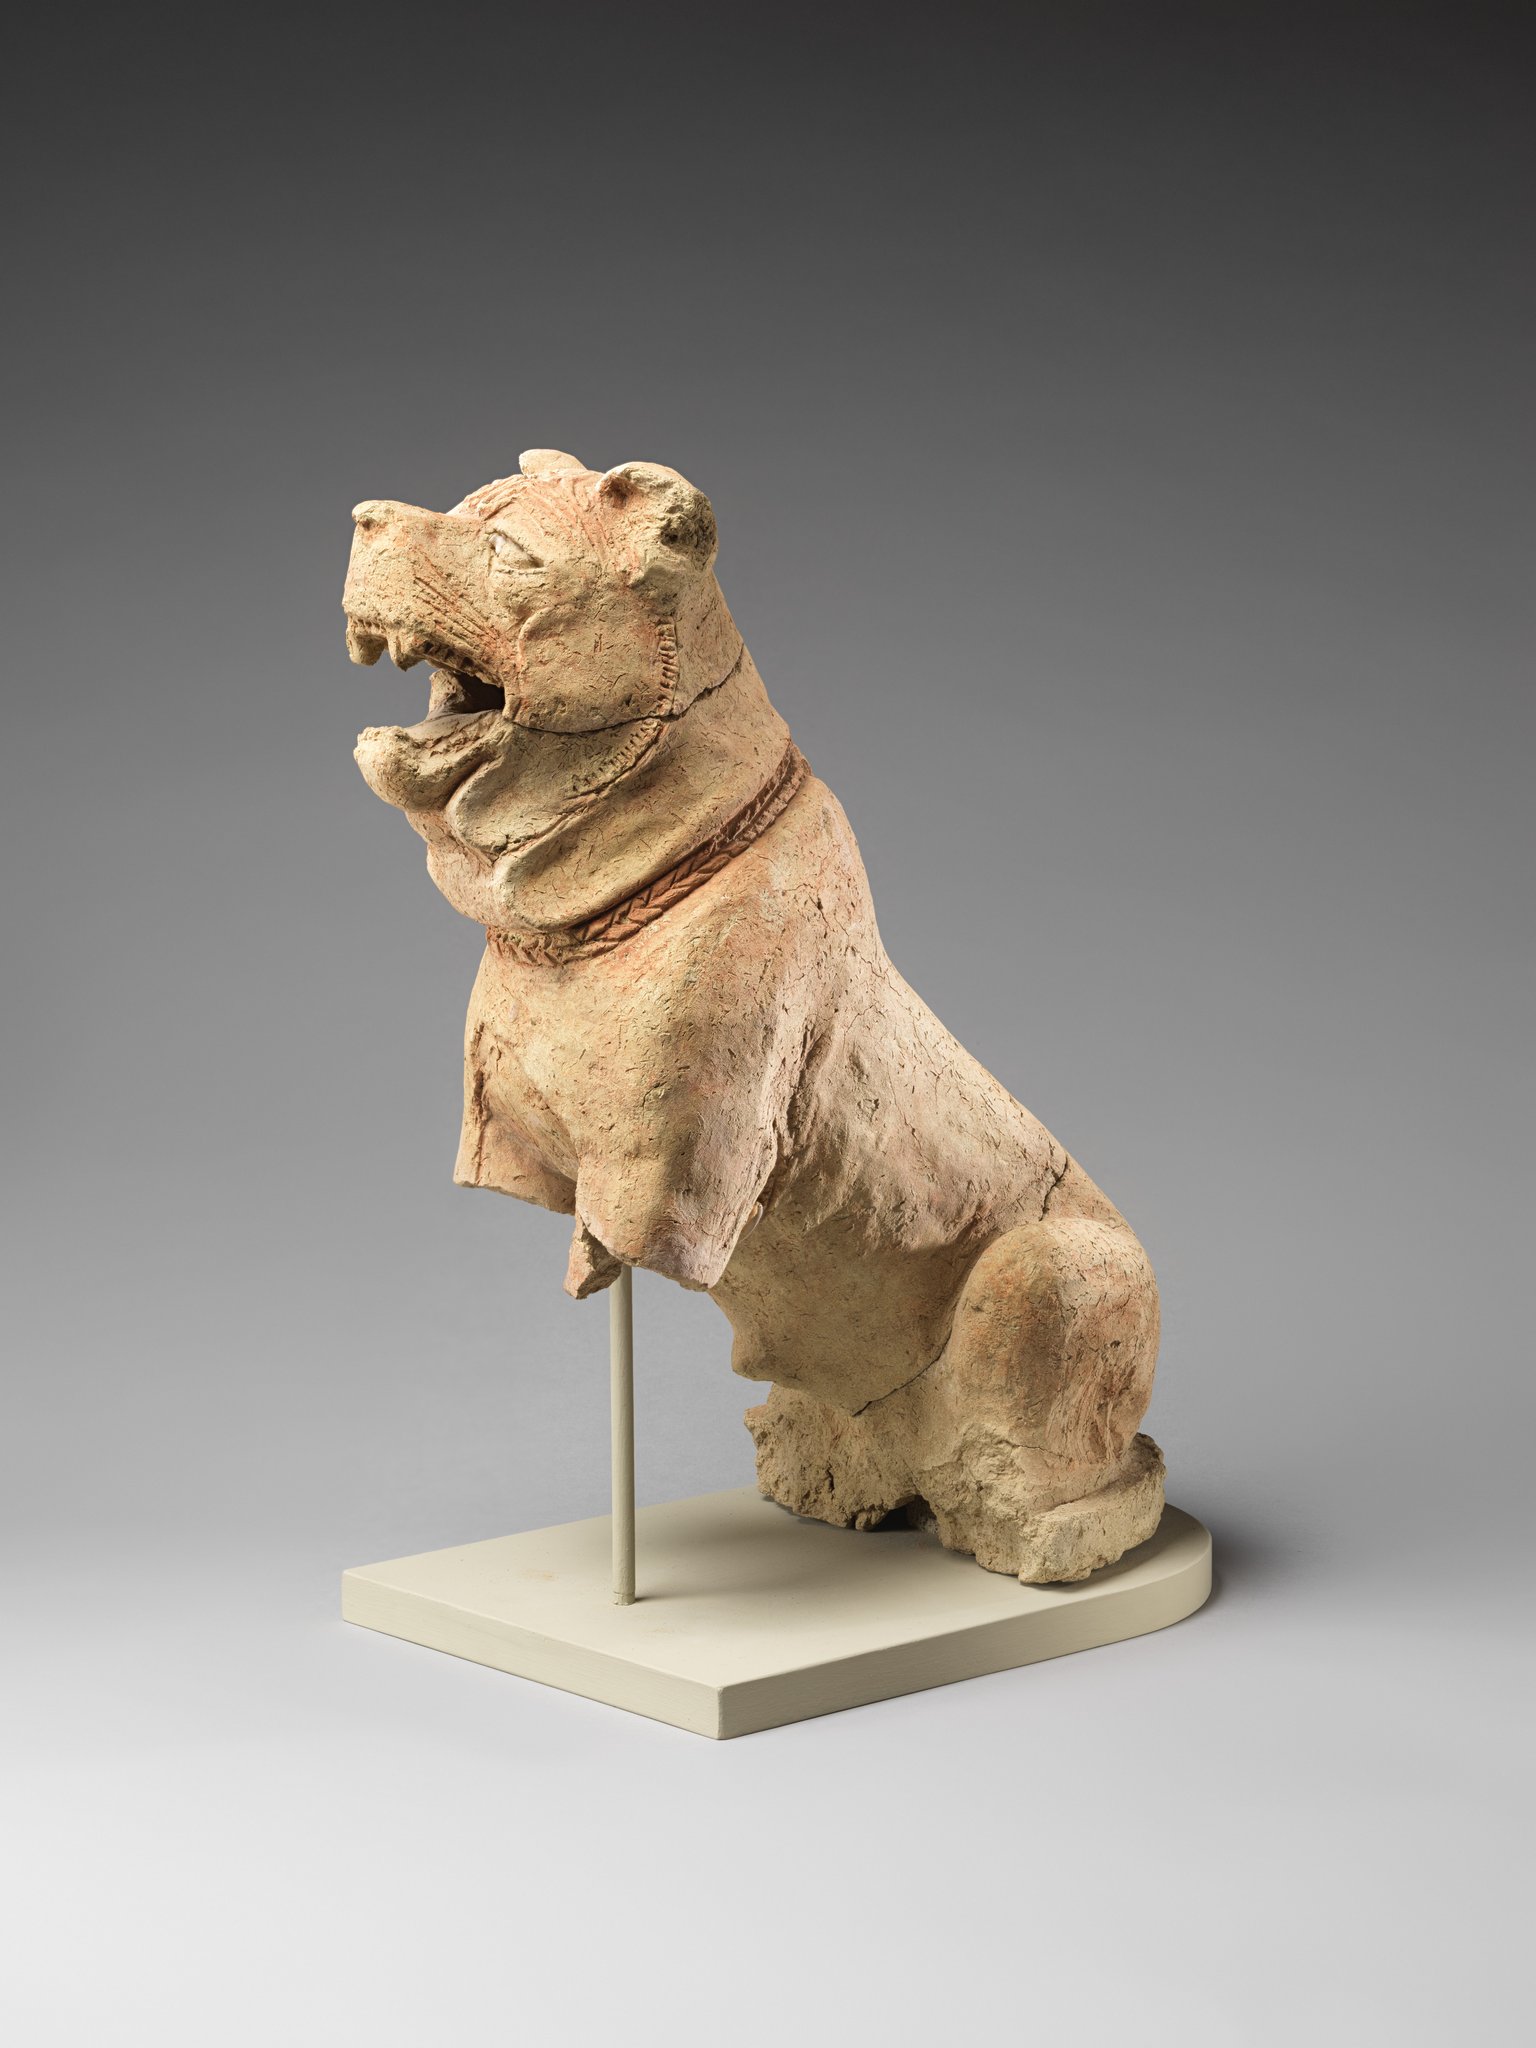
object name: sculpture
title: Mastiff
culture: kassite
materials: ceramic, paint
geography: mesopotamia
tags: dogs